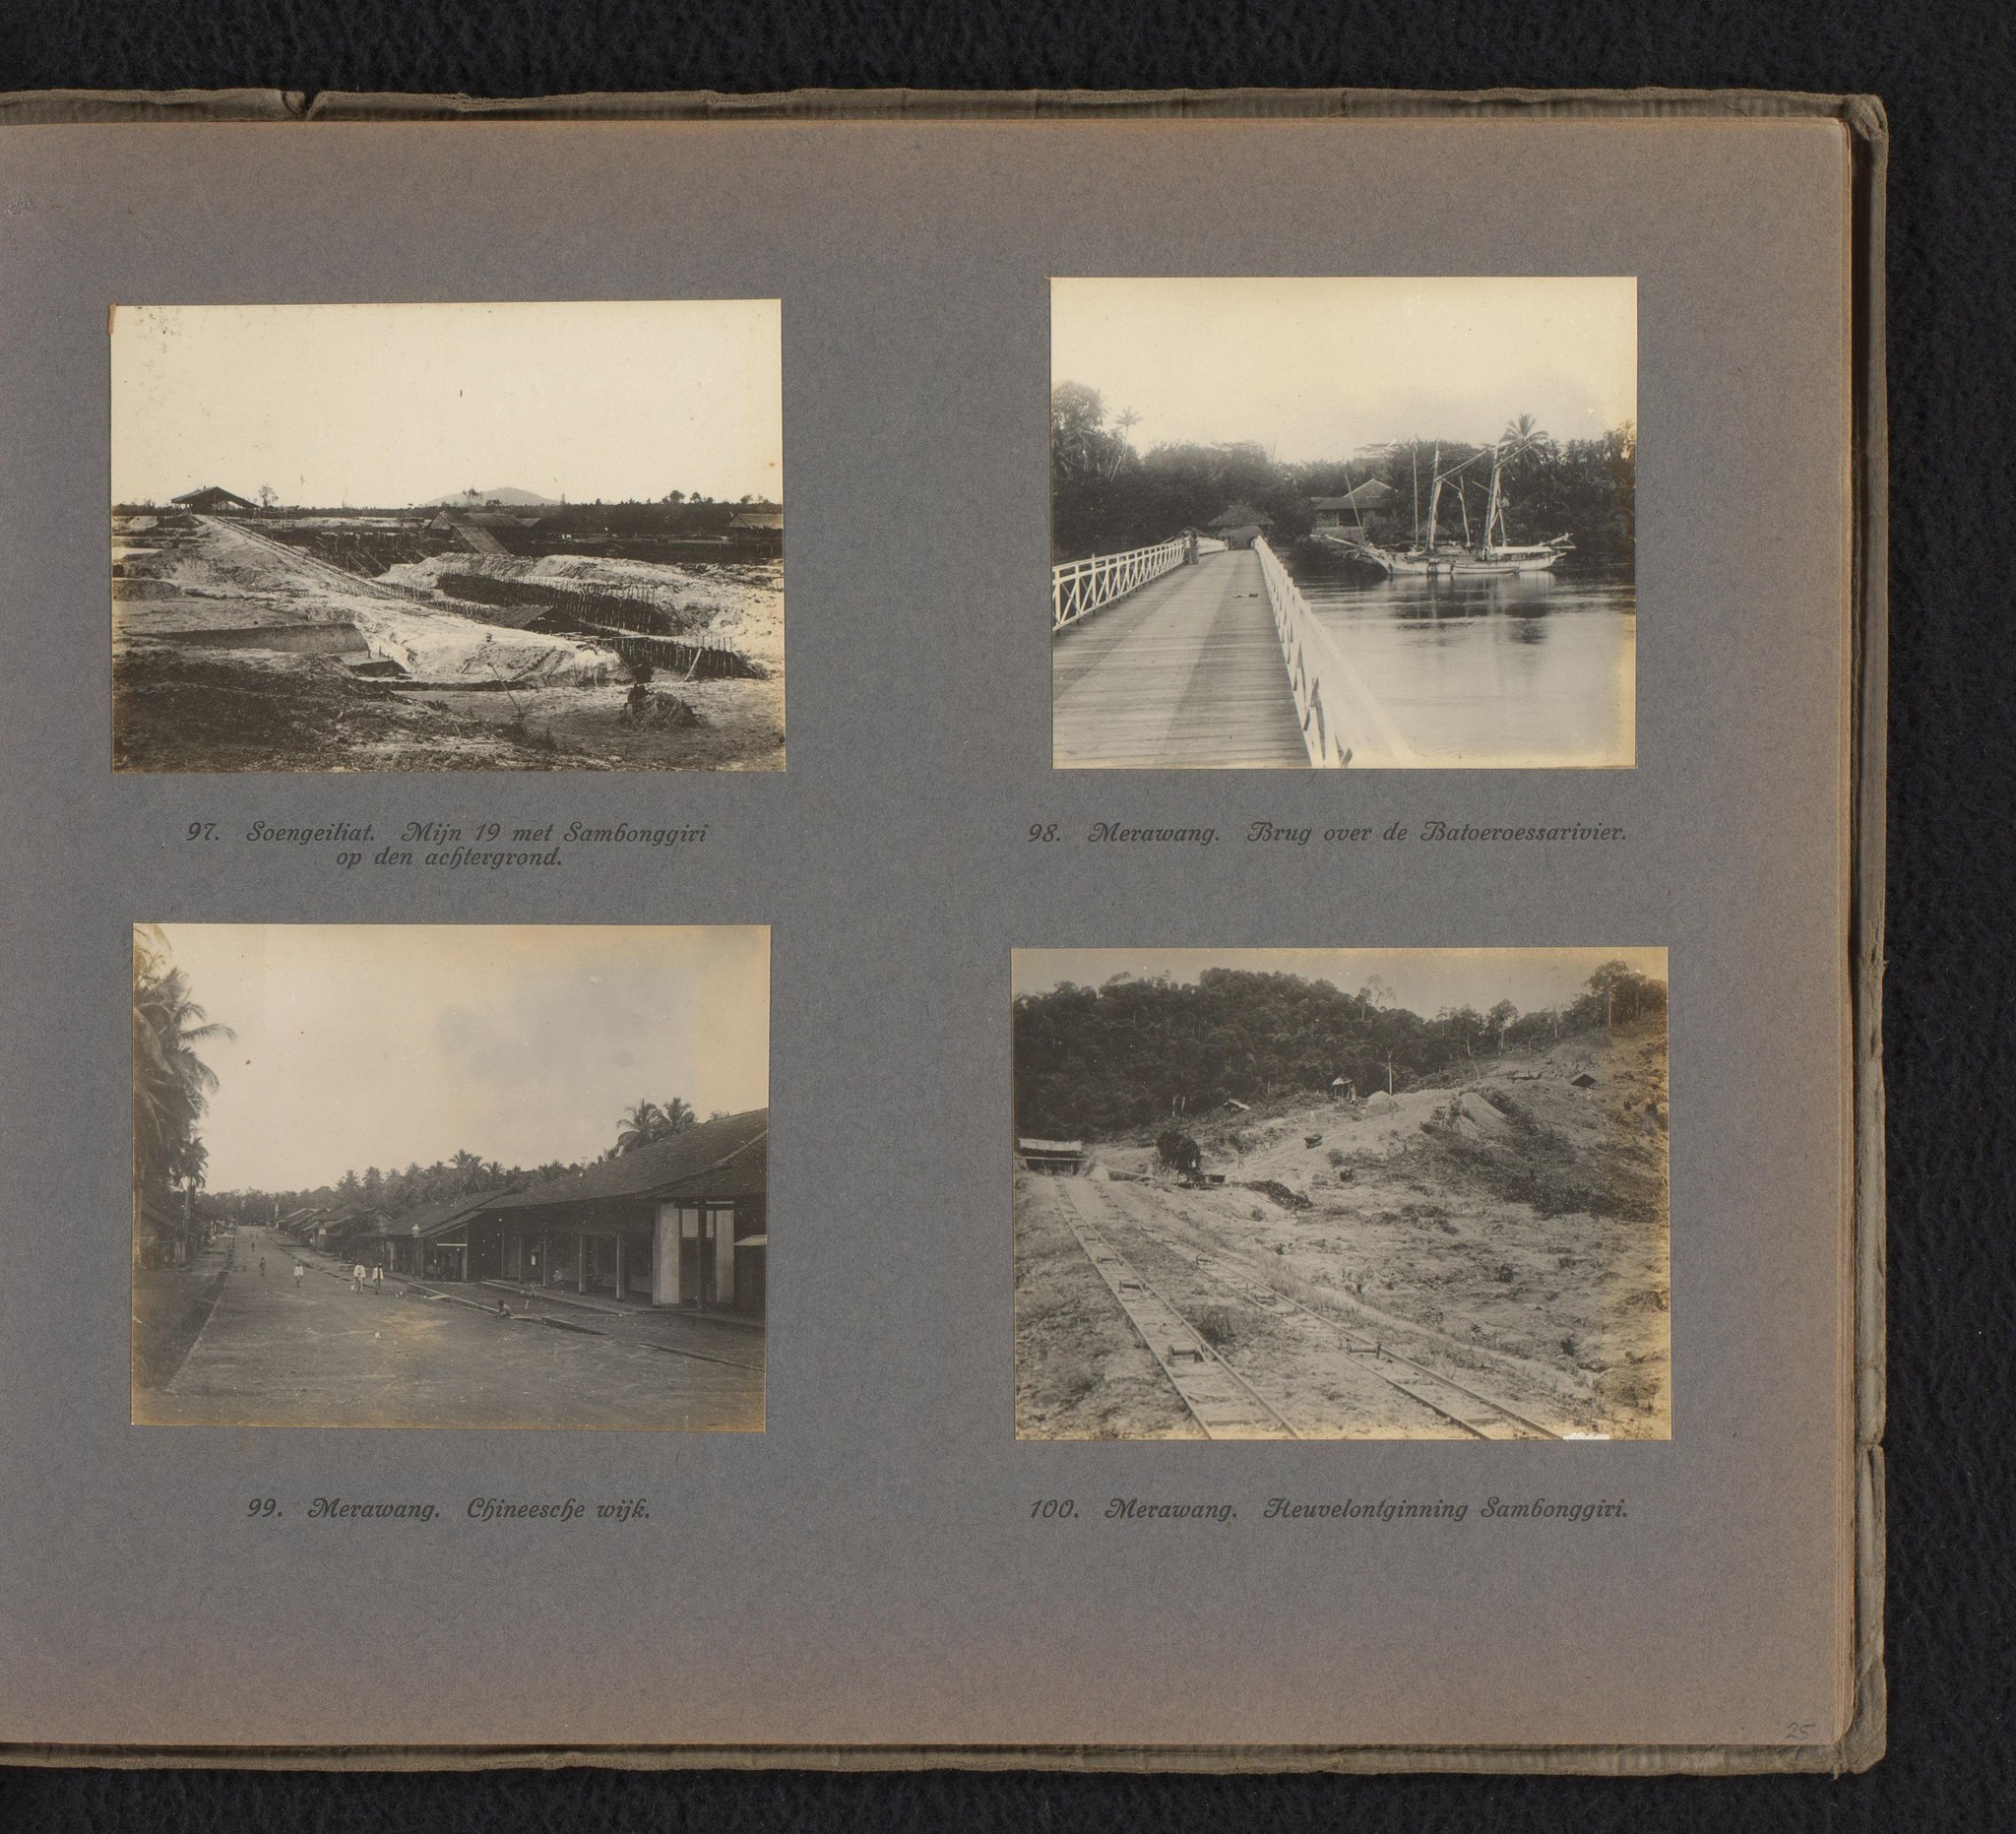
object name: album leaf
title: Gezichten te Soengeiliat en Merawang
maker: Anonymous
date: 1907-1919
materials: cardboard, photographic support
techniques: gelatin silver print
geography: bangka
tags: robert julius boers, colonial system, opencast mine; strip mining, minerals and metals: tin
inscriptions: inscription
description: Albumblad met vier foto's genummerd 97-100 van verschillende gezichten te Soengeiliat en Merawang op Banka: groeve, brug en Chinese wijk. Onderdeel van het Banka-Album met foto's over het eiland Banka en de tinwinning door het staatsbedrijf de Banka-tinwinning in de periode ca. 1907-1919.